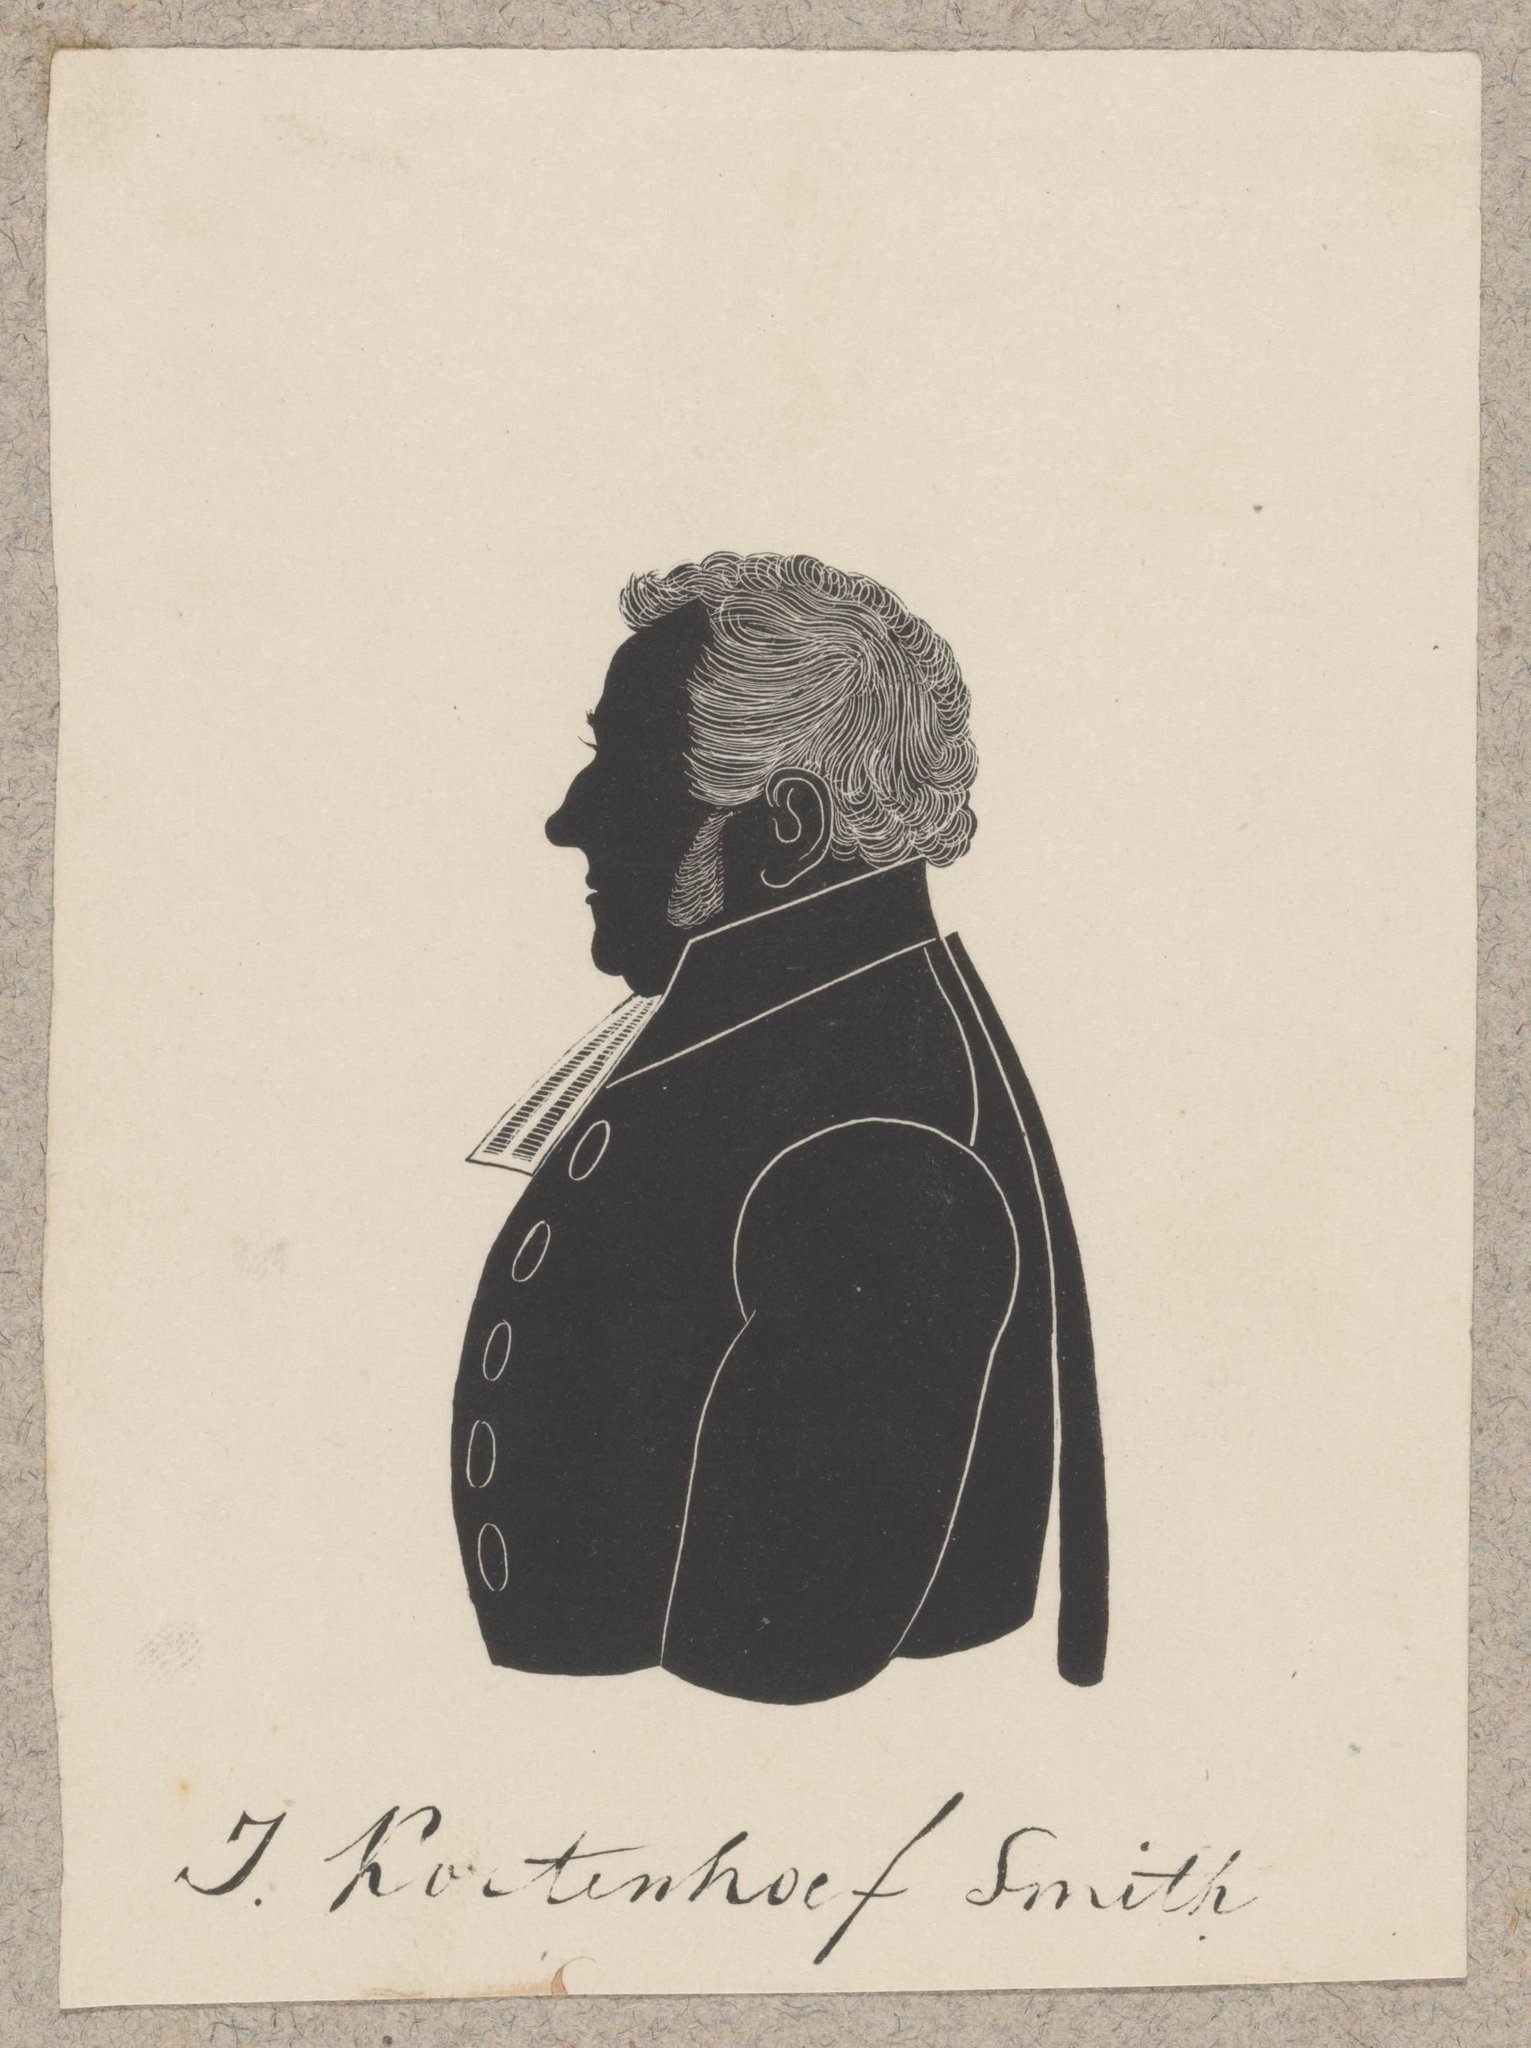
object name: print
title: Silhouetportret van Jan Kortenhoef Smith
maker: pieter barbiers (iv)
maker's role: painter, print maker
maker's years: 1798-1848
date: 1809-1848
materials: paper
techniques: hand coloring, lithograph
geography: netherlands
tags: historical persons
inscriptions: collector's mark: Lugt 2228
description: Onder het portret de signatuur van de geportretteerde.